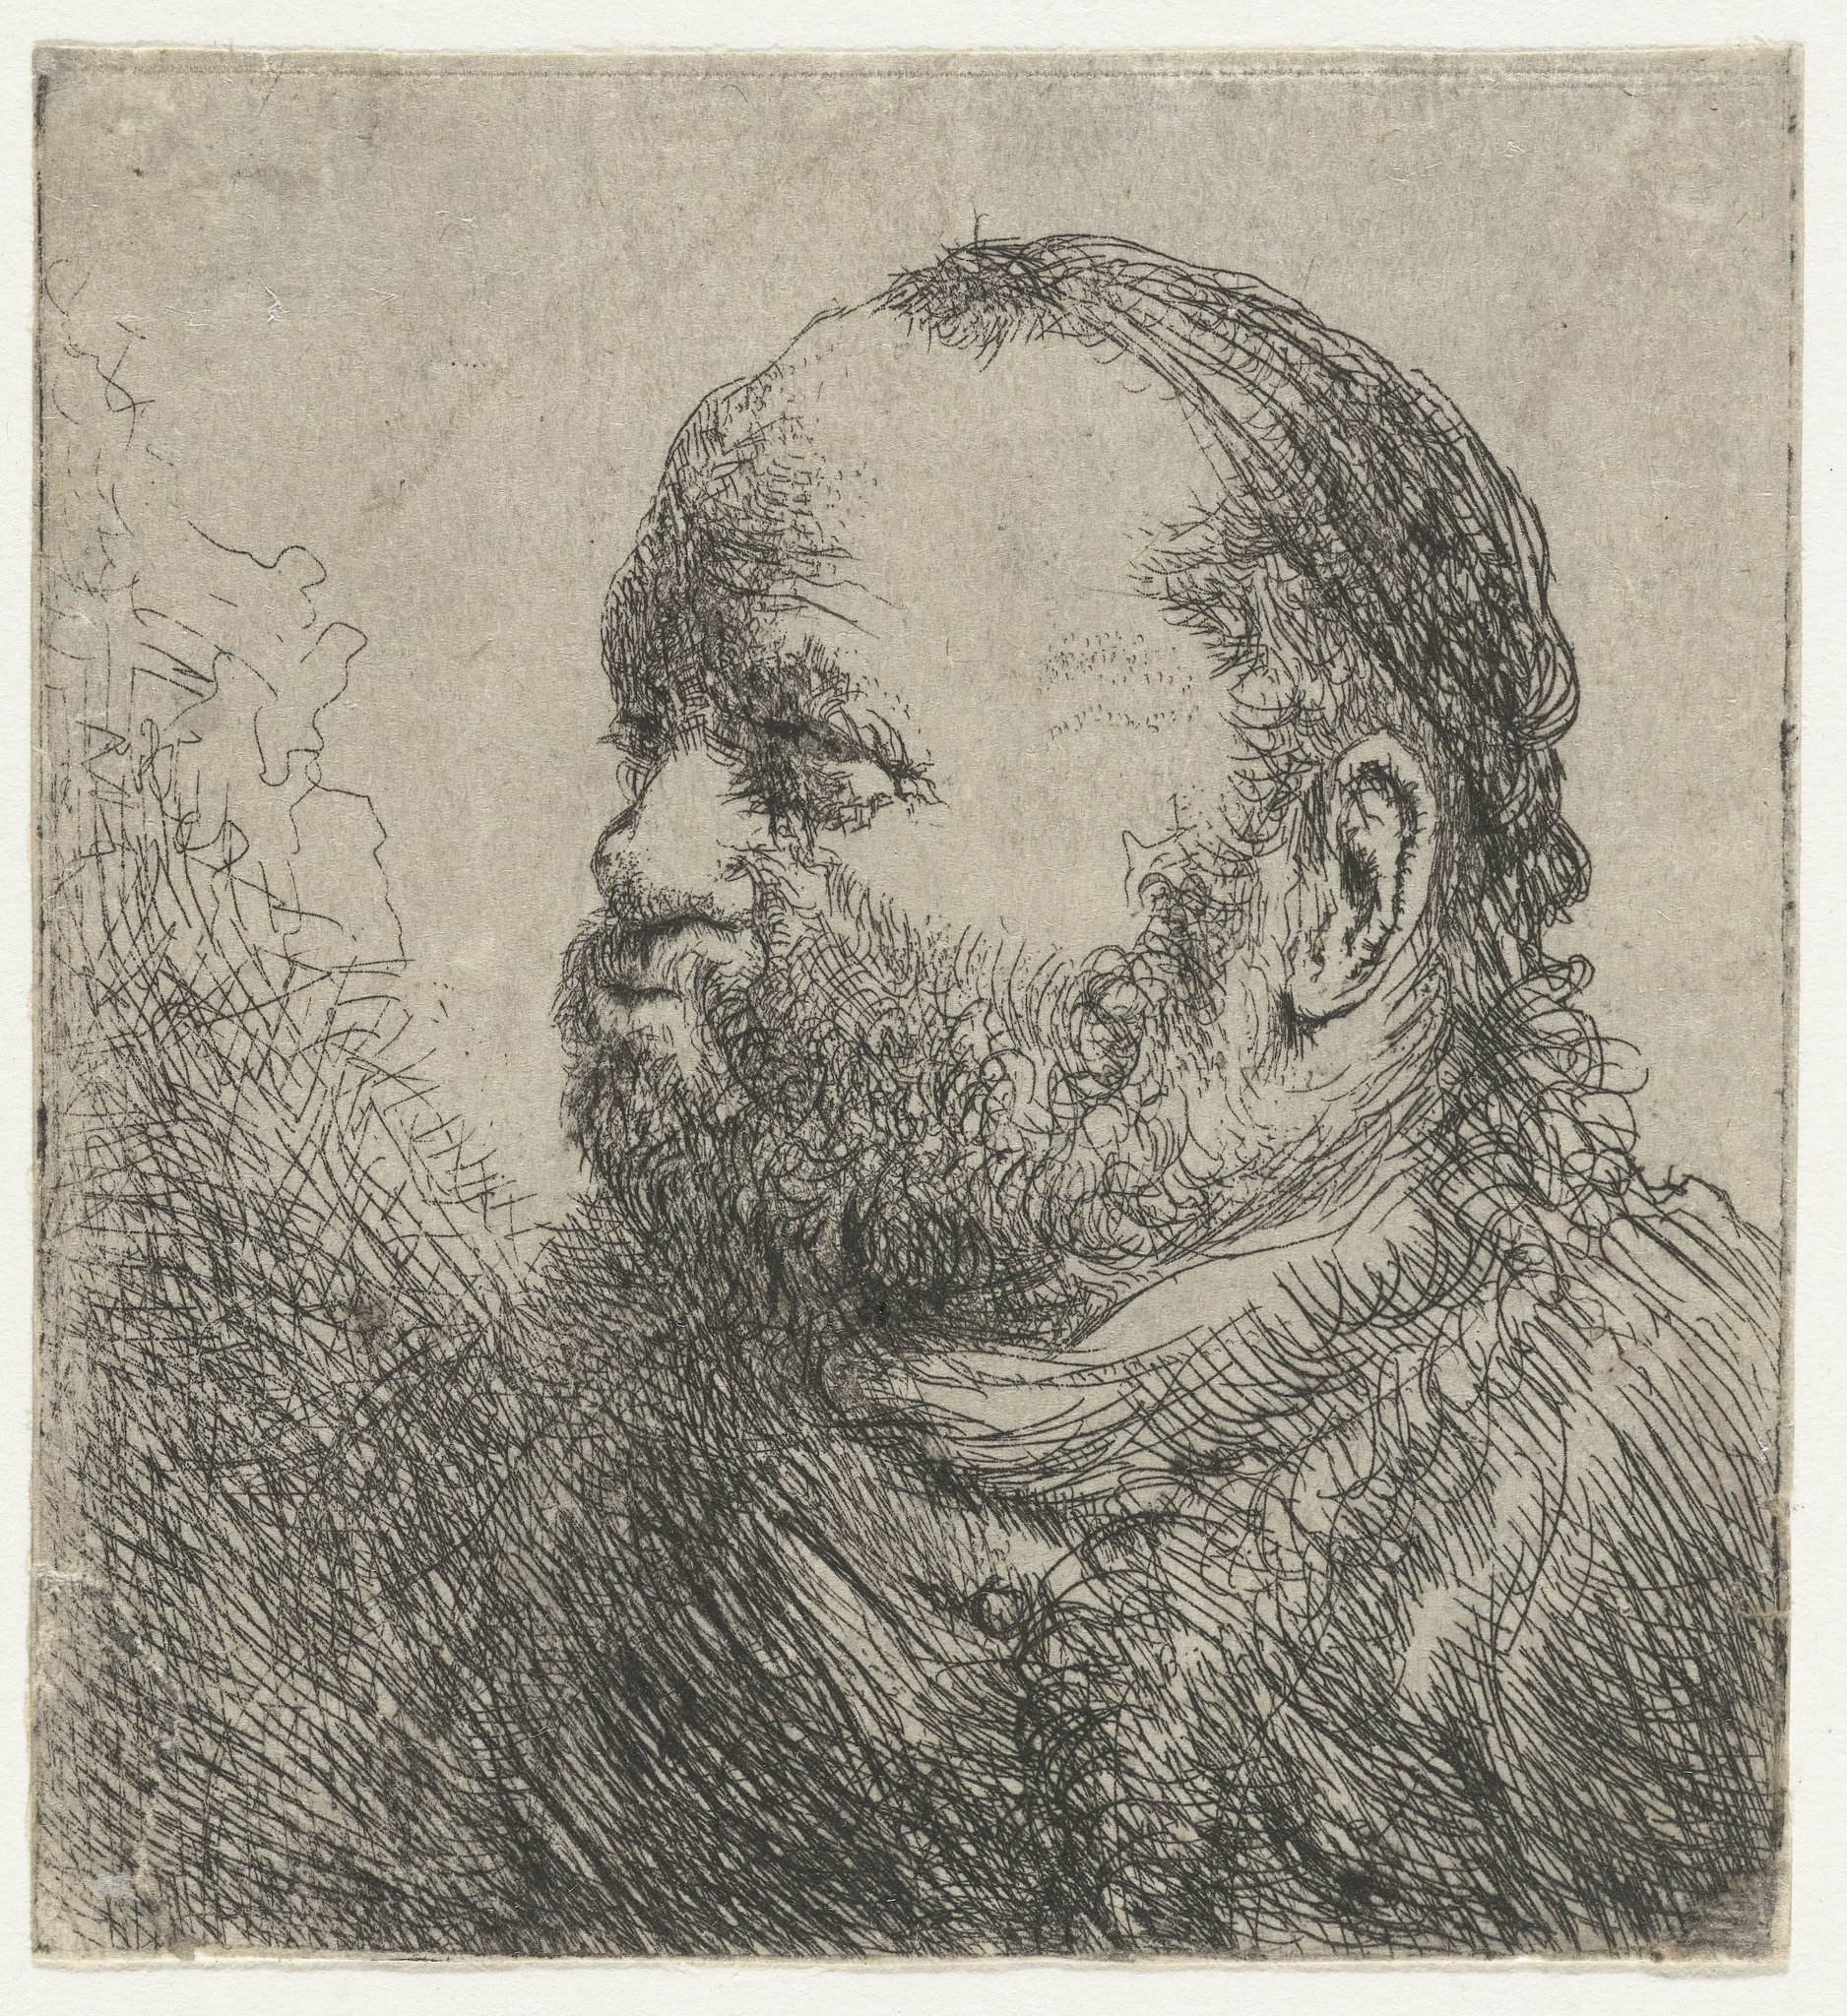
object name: print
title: Borstbeeld van een man met dikke lippen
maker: jan lievens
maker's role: draughtsman, painter, print maker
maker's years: 1607-1674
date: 1625-1674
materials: paper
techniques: etching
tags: adult man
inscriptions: collector's mark: Lugt 240